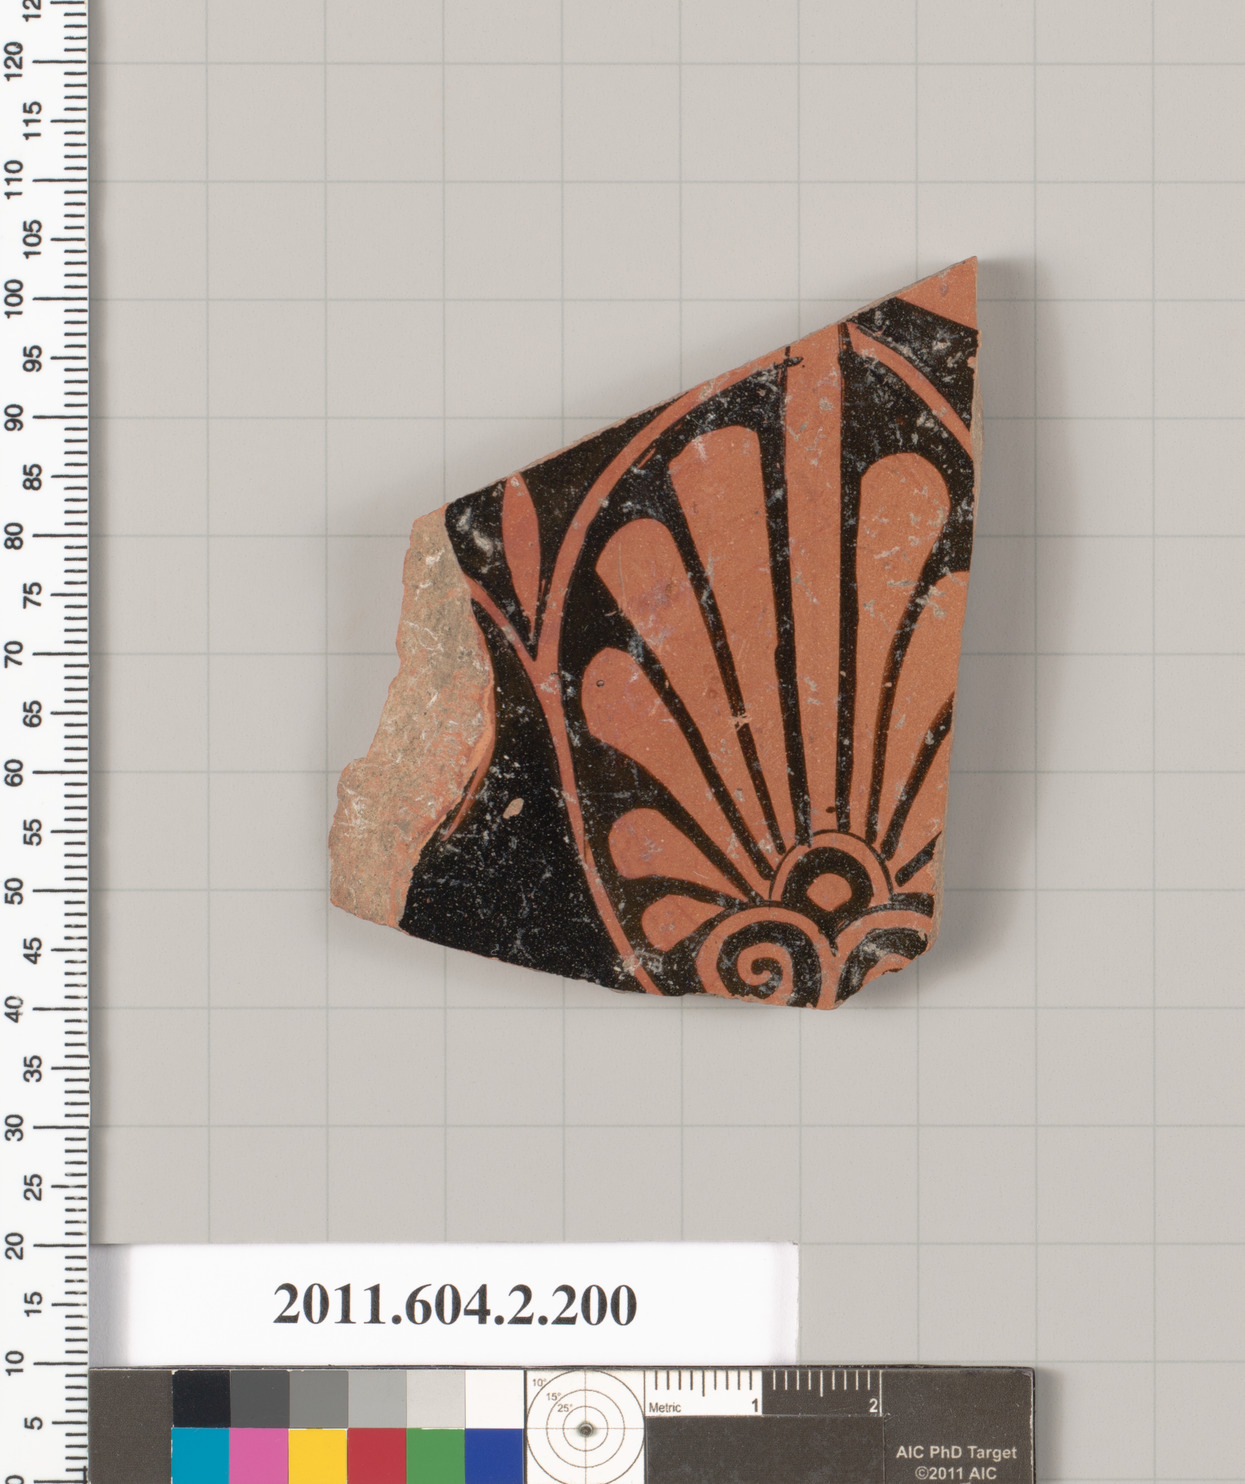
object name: stamnos fragment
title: Terracotta fragment of a stamnos (jar)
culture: greek, attic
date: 520-490 BCE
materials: terracotta